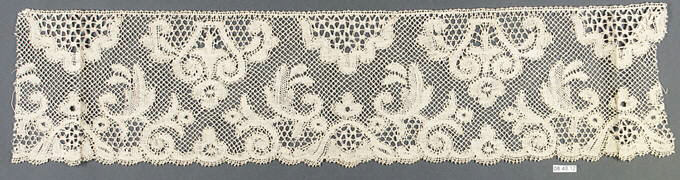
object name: edging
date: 1801-1900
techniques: lace